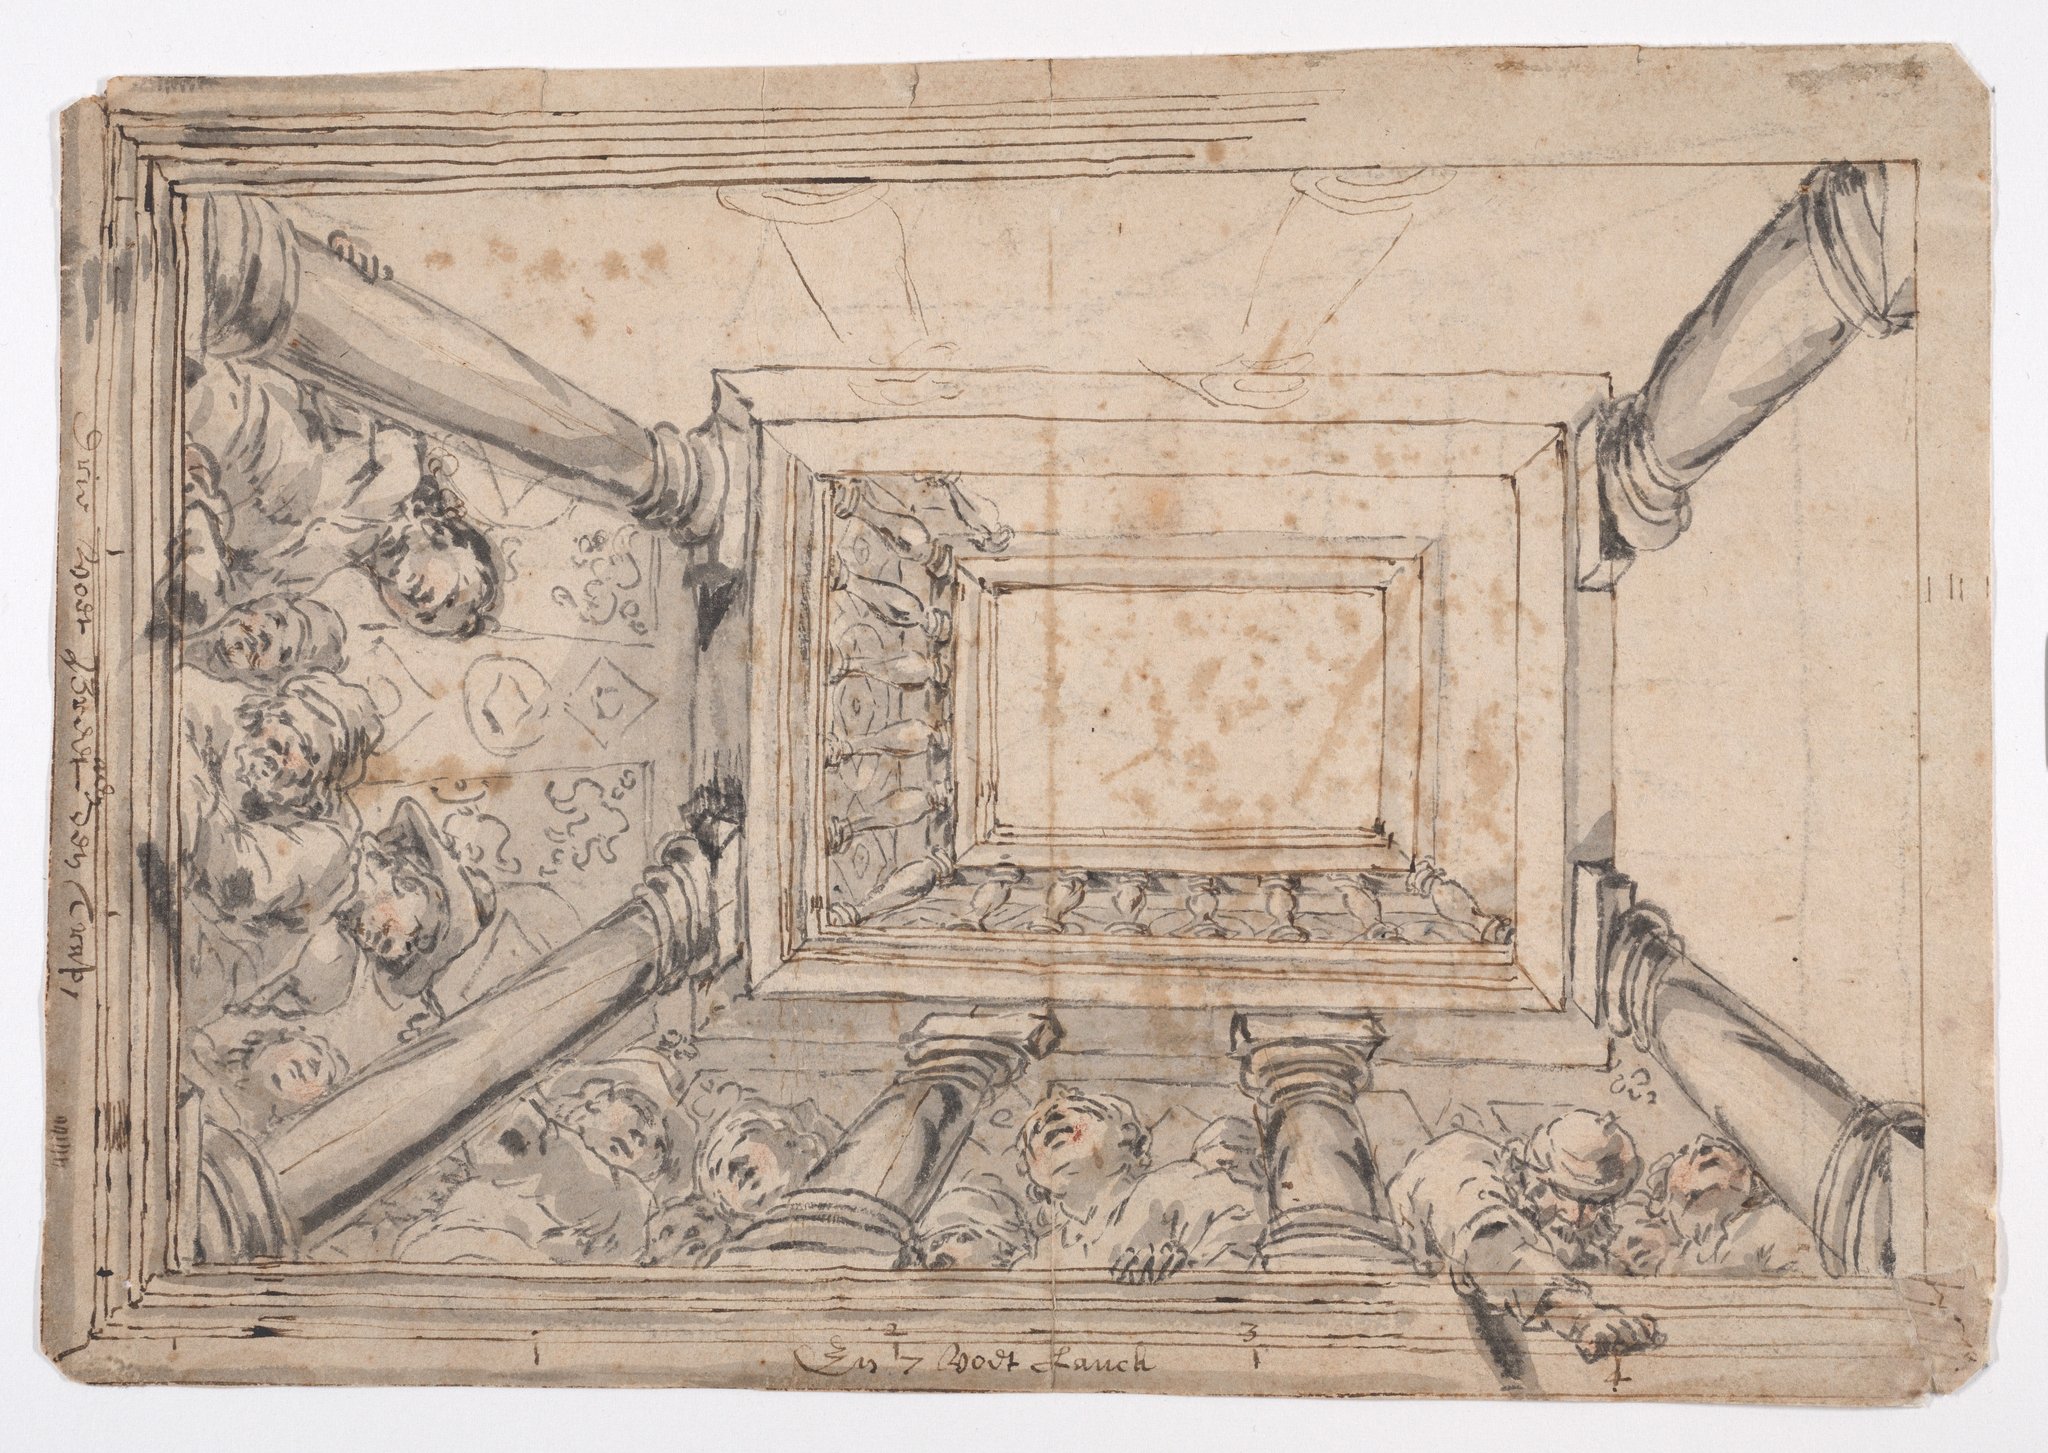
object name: drawing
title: A Design for a Ceiling Decoration with Figures Looking down from a Pillared Gallery (recto); Figure Sketches (verso)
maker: leonaert bramer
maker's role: artist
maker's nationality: dutch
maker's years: 1596-1674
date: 1634-1666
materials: chalk, ink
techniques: brush, pen, wash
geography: netherlands